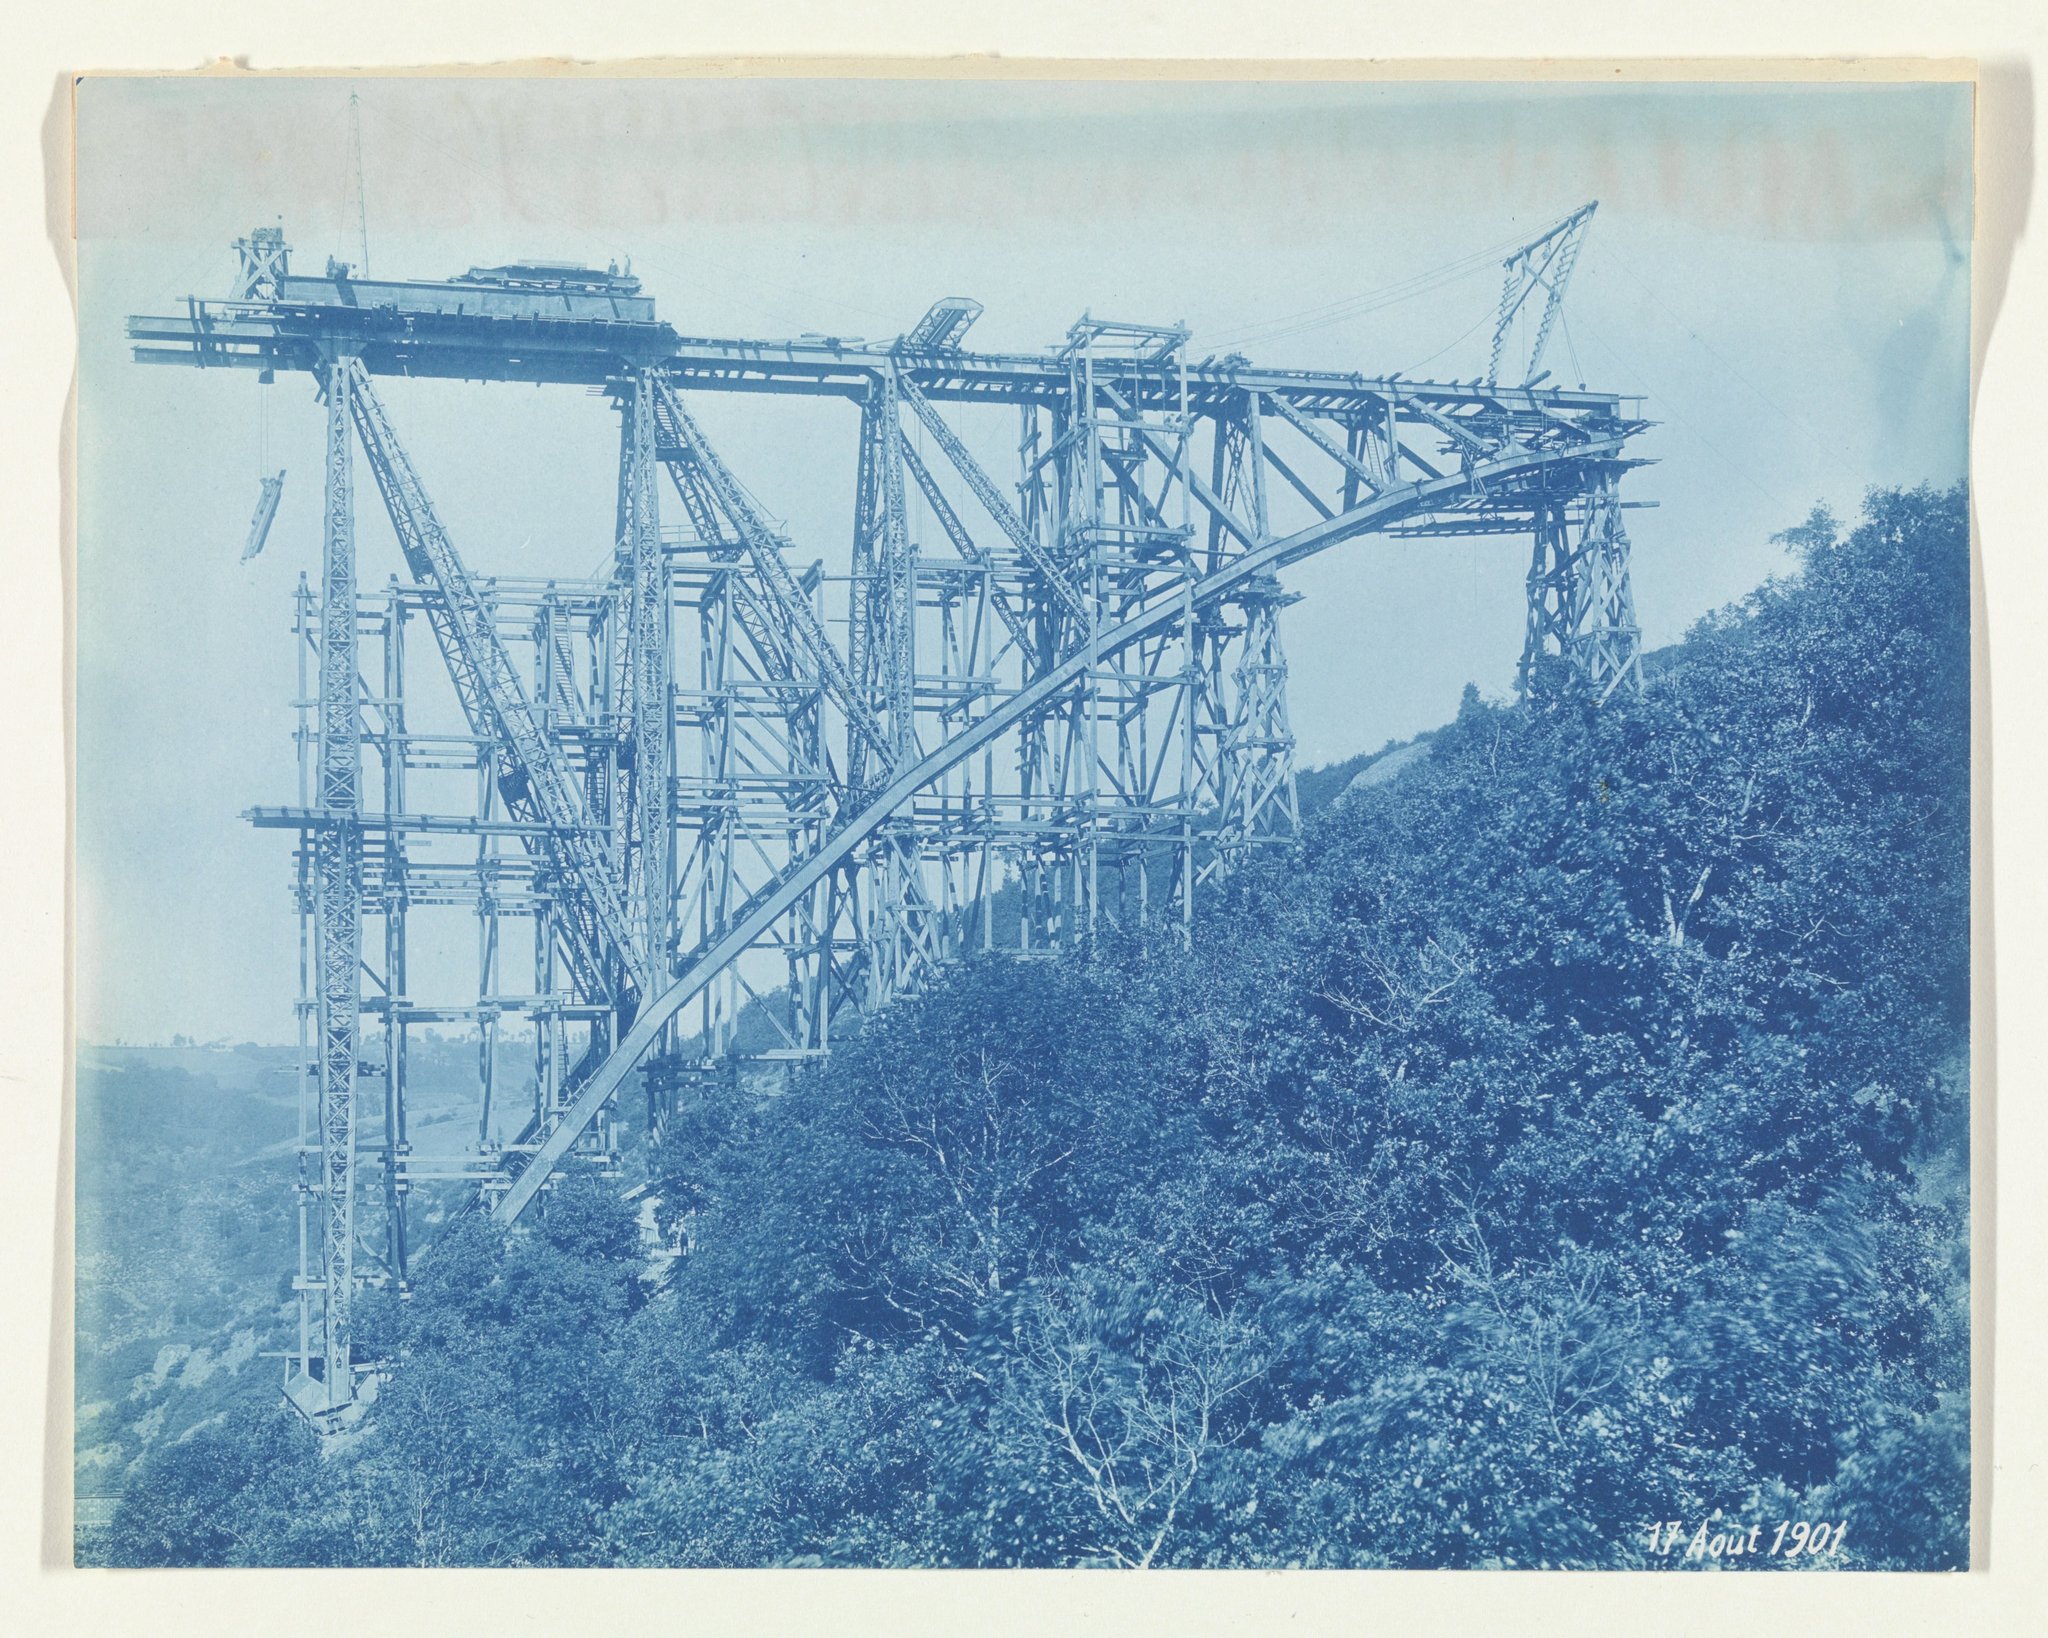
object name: photograph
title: Aanleg van het Viaur Viaduct in Frankrijk door de Societé de Construction des Battignolles, 17 augustus 1901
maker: Anonymous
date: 1901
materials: photographic support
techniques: cyanotype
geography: france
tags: viaduct, making the overground structures (~ building activities)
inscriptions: date